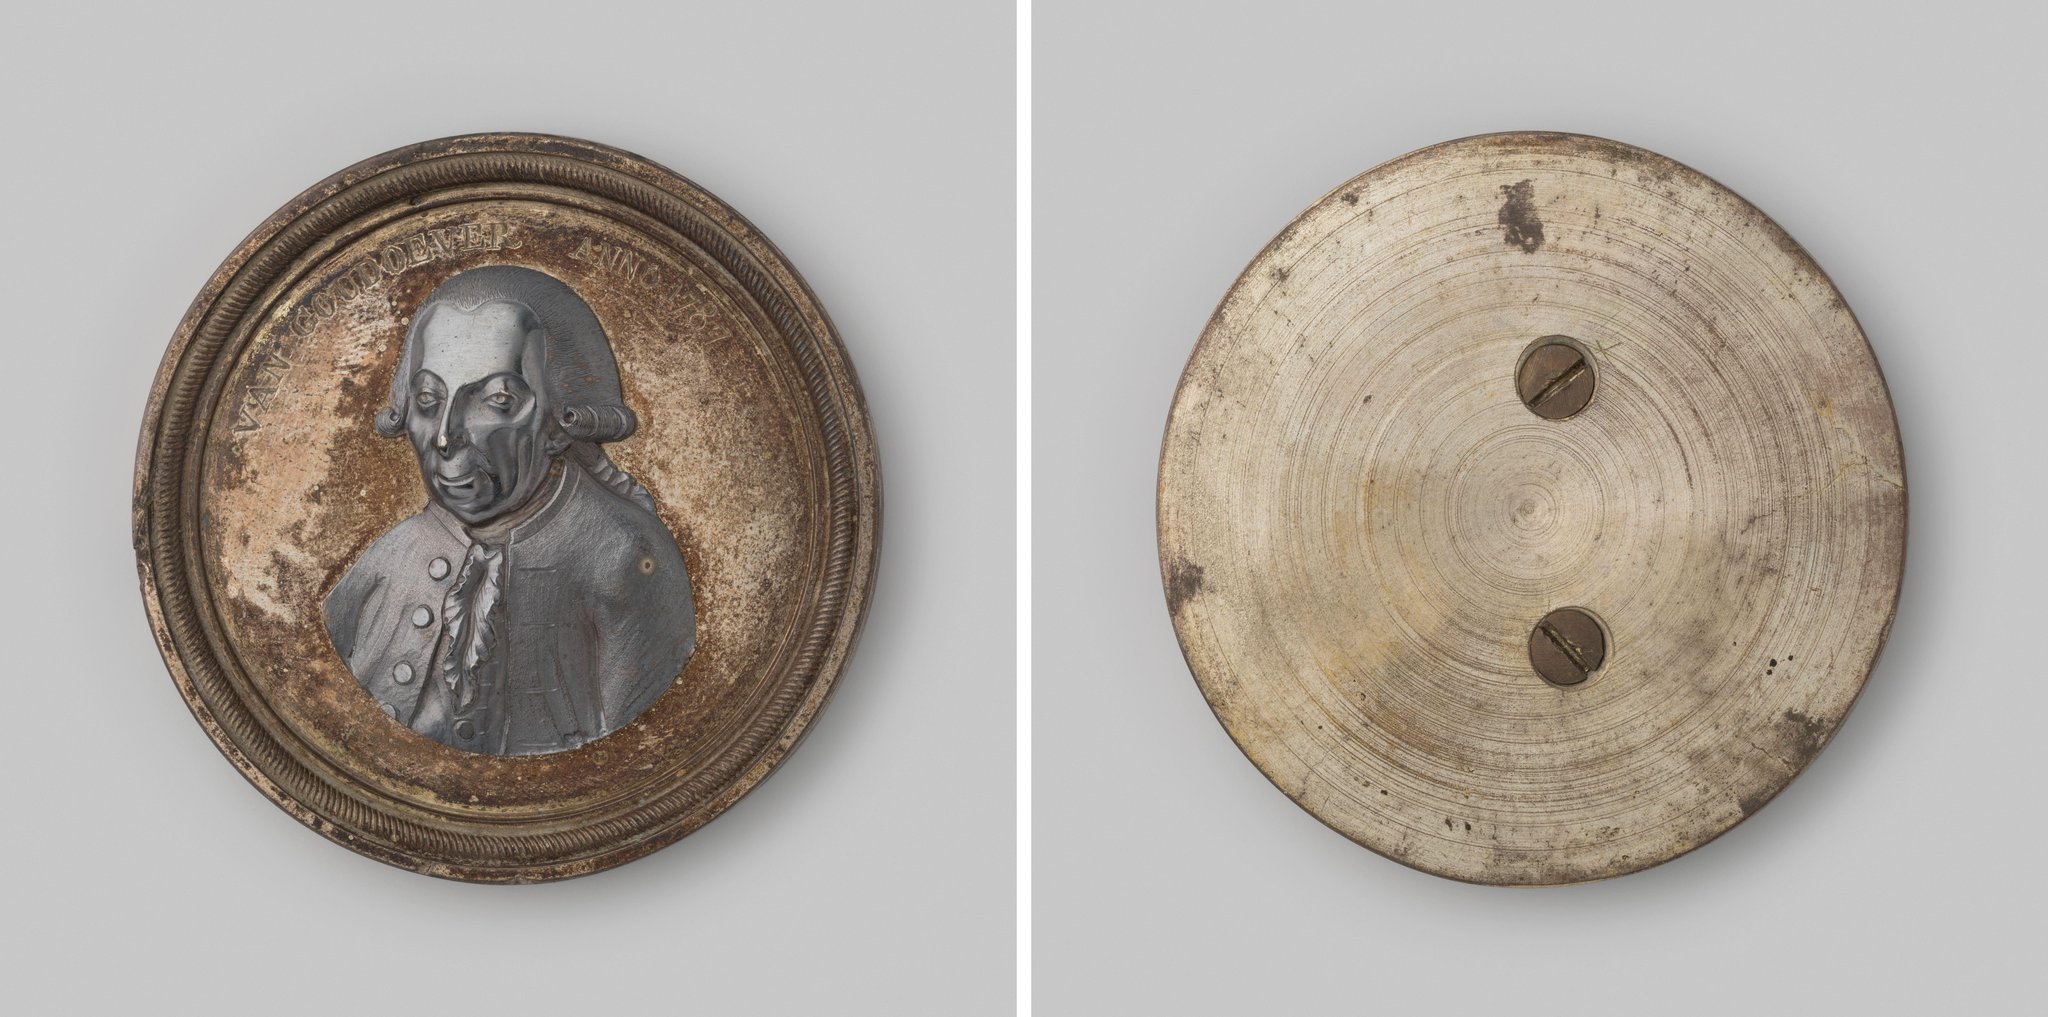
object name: history medal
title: Portret van Isaac van Goudoever, kolonel van de schutterij te Amsterdam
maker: Anonymous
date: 1787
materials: metal, silver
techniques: screwed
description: Zilveren borstbeeld op wit metaal. Omschrift: VAN GOUDOEVER ANNO 1787